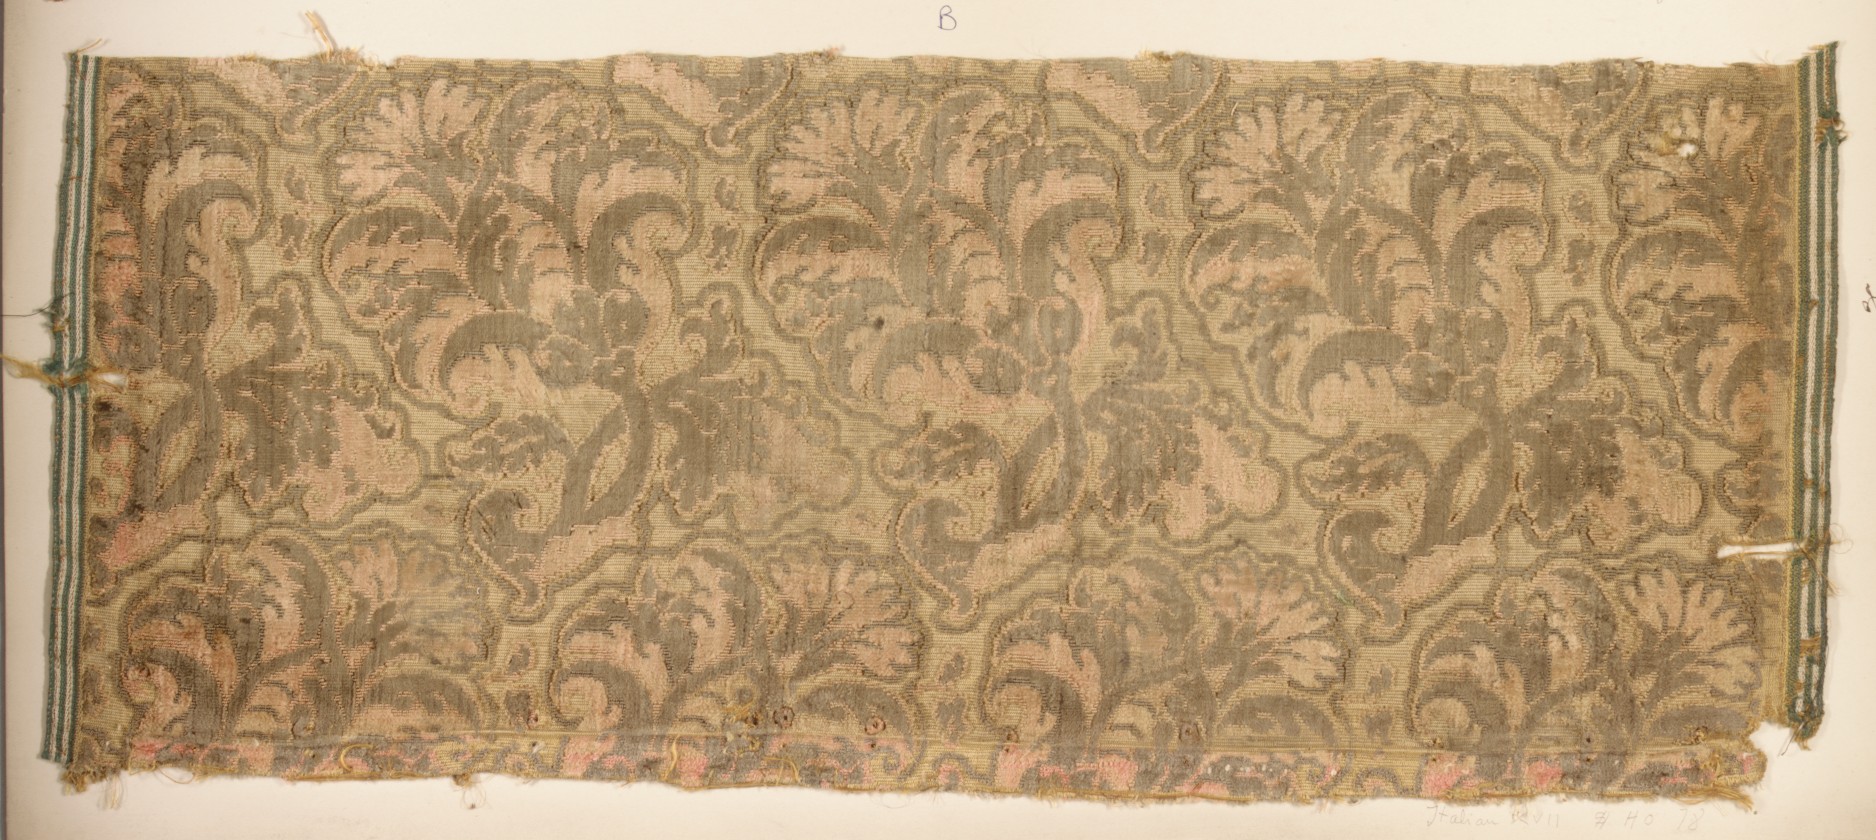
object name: fragment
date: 1601-1700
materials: metal thread, silk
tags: flowers,leaves